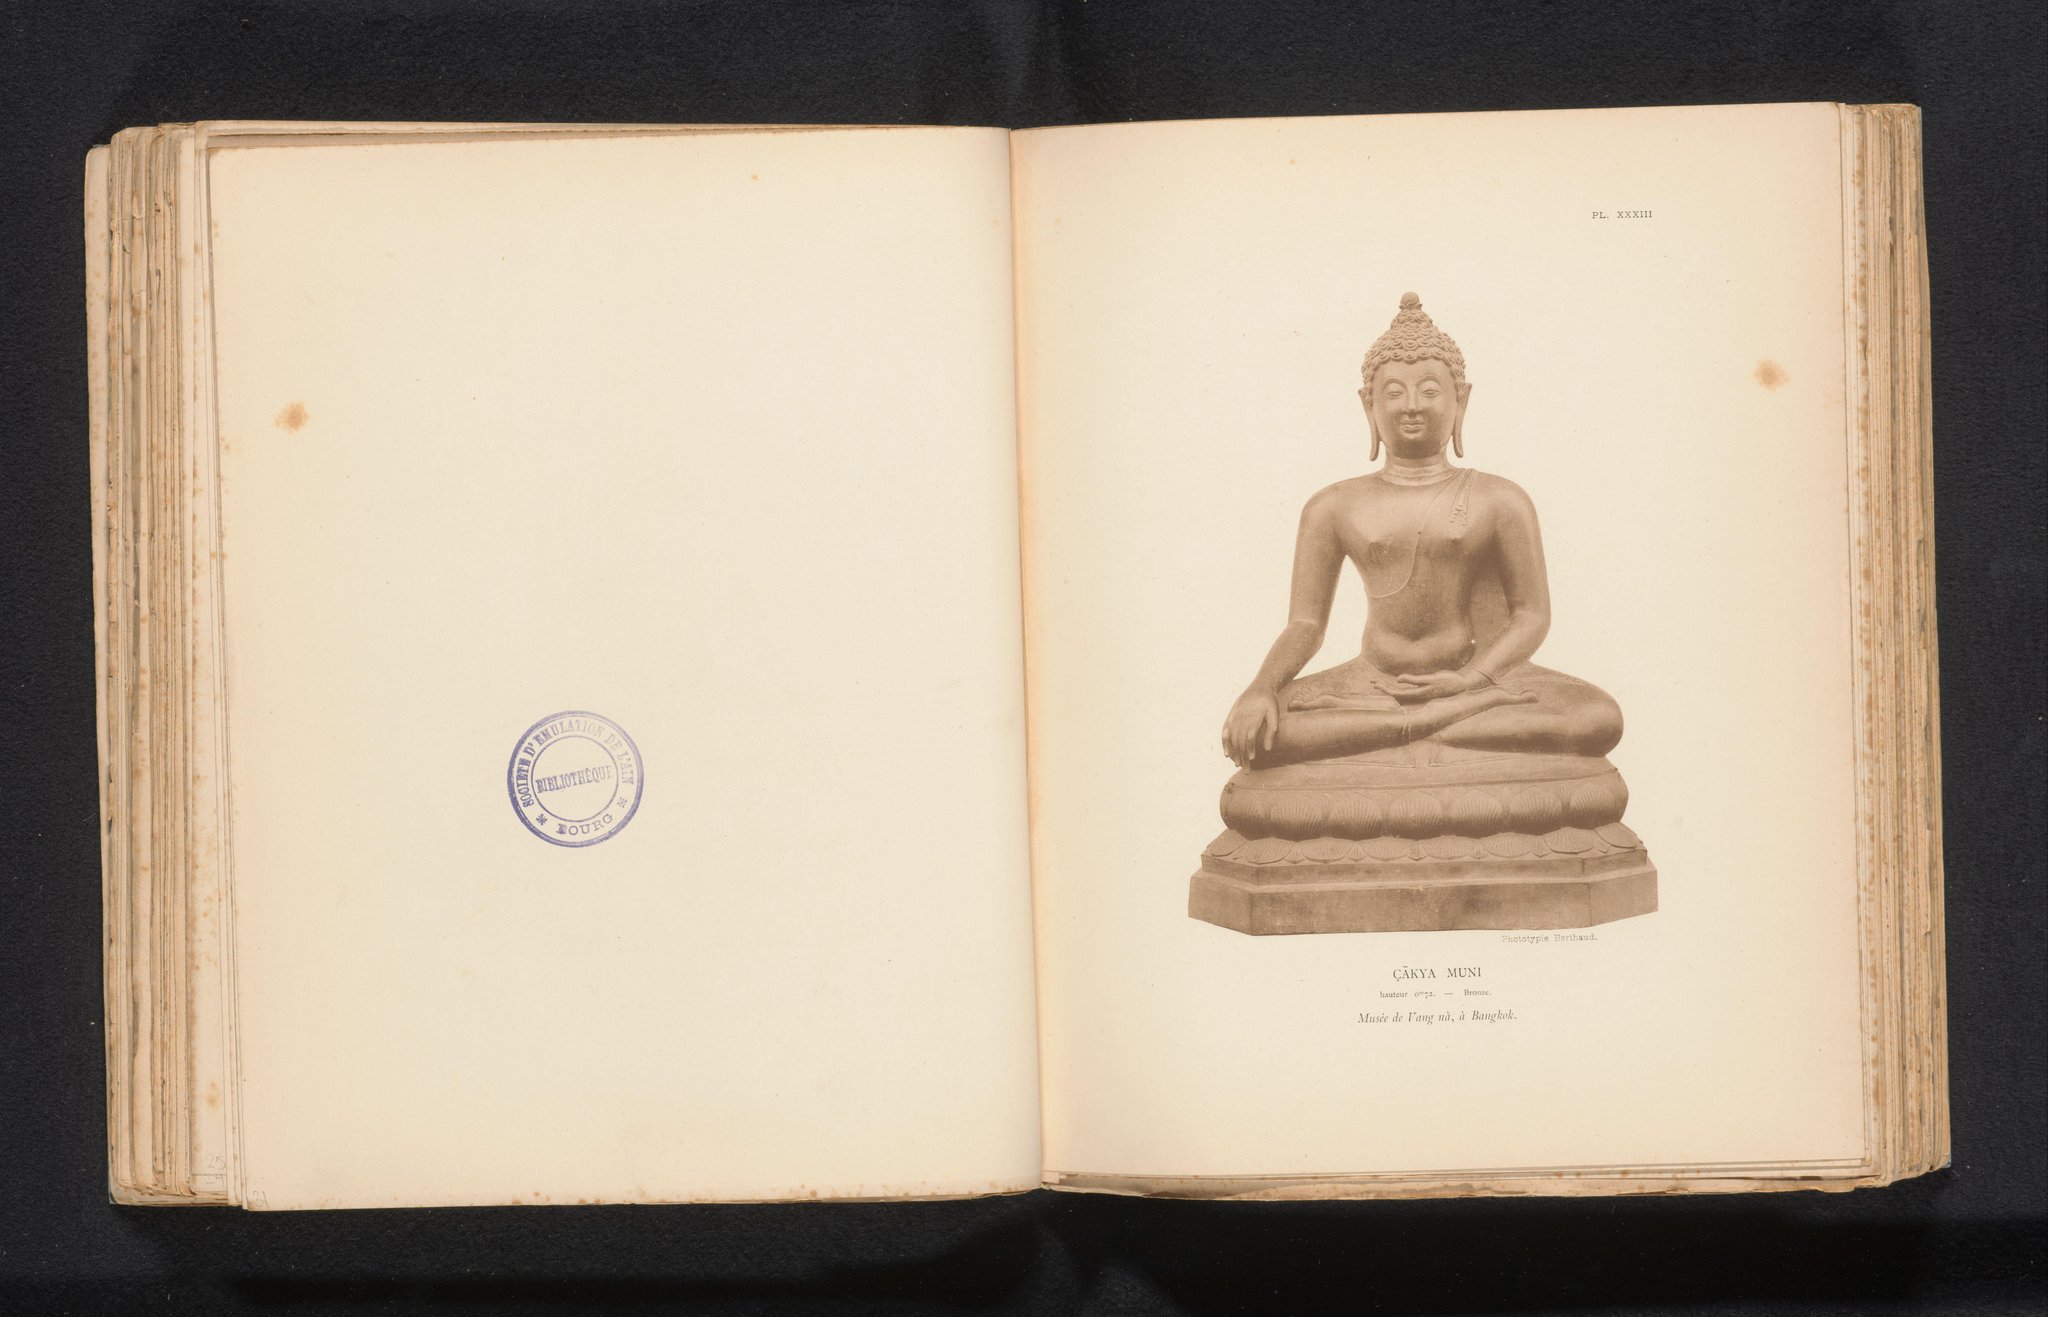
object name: photomechanical print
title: Sculptuur van Boeddha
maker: michel berthaud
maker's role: publisher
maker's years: 1845-1912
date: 1890-1895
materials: paper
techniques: photograph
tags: representations ~ gods, demi-gods, heroes, etc. (hinduism, buddhism, jainism)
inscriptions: inscription: ‘hauteur 0m72 - Bronze/ Musée de Vang nà, à Bangkok’, collector's mark: ‘Société d'Emulation de l'Ain/ Bourg/ Bibliothèque’, inscription: ‘Pl. XXXIII’